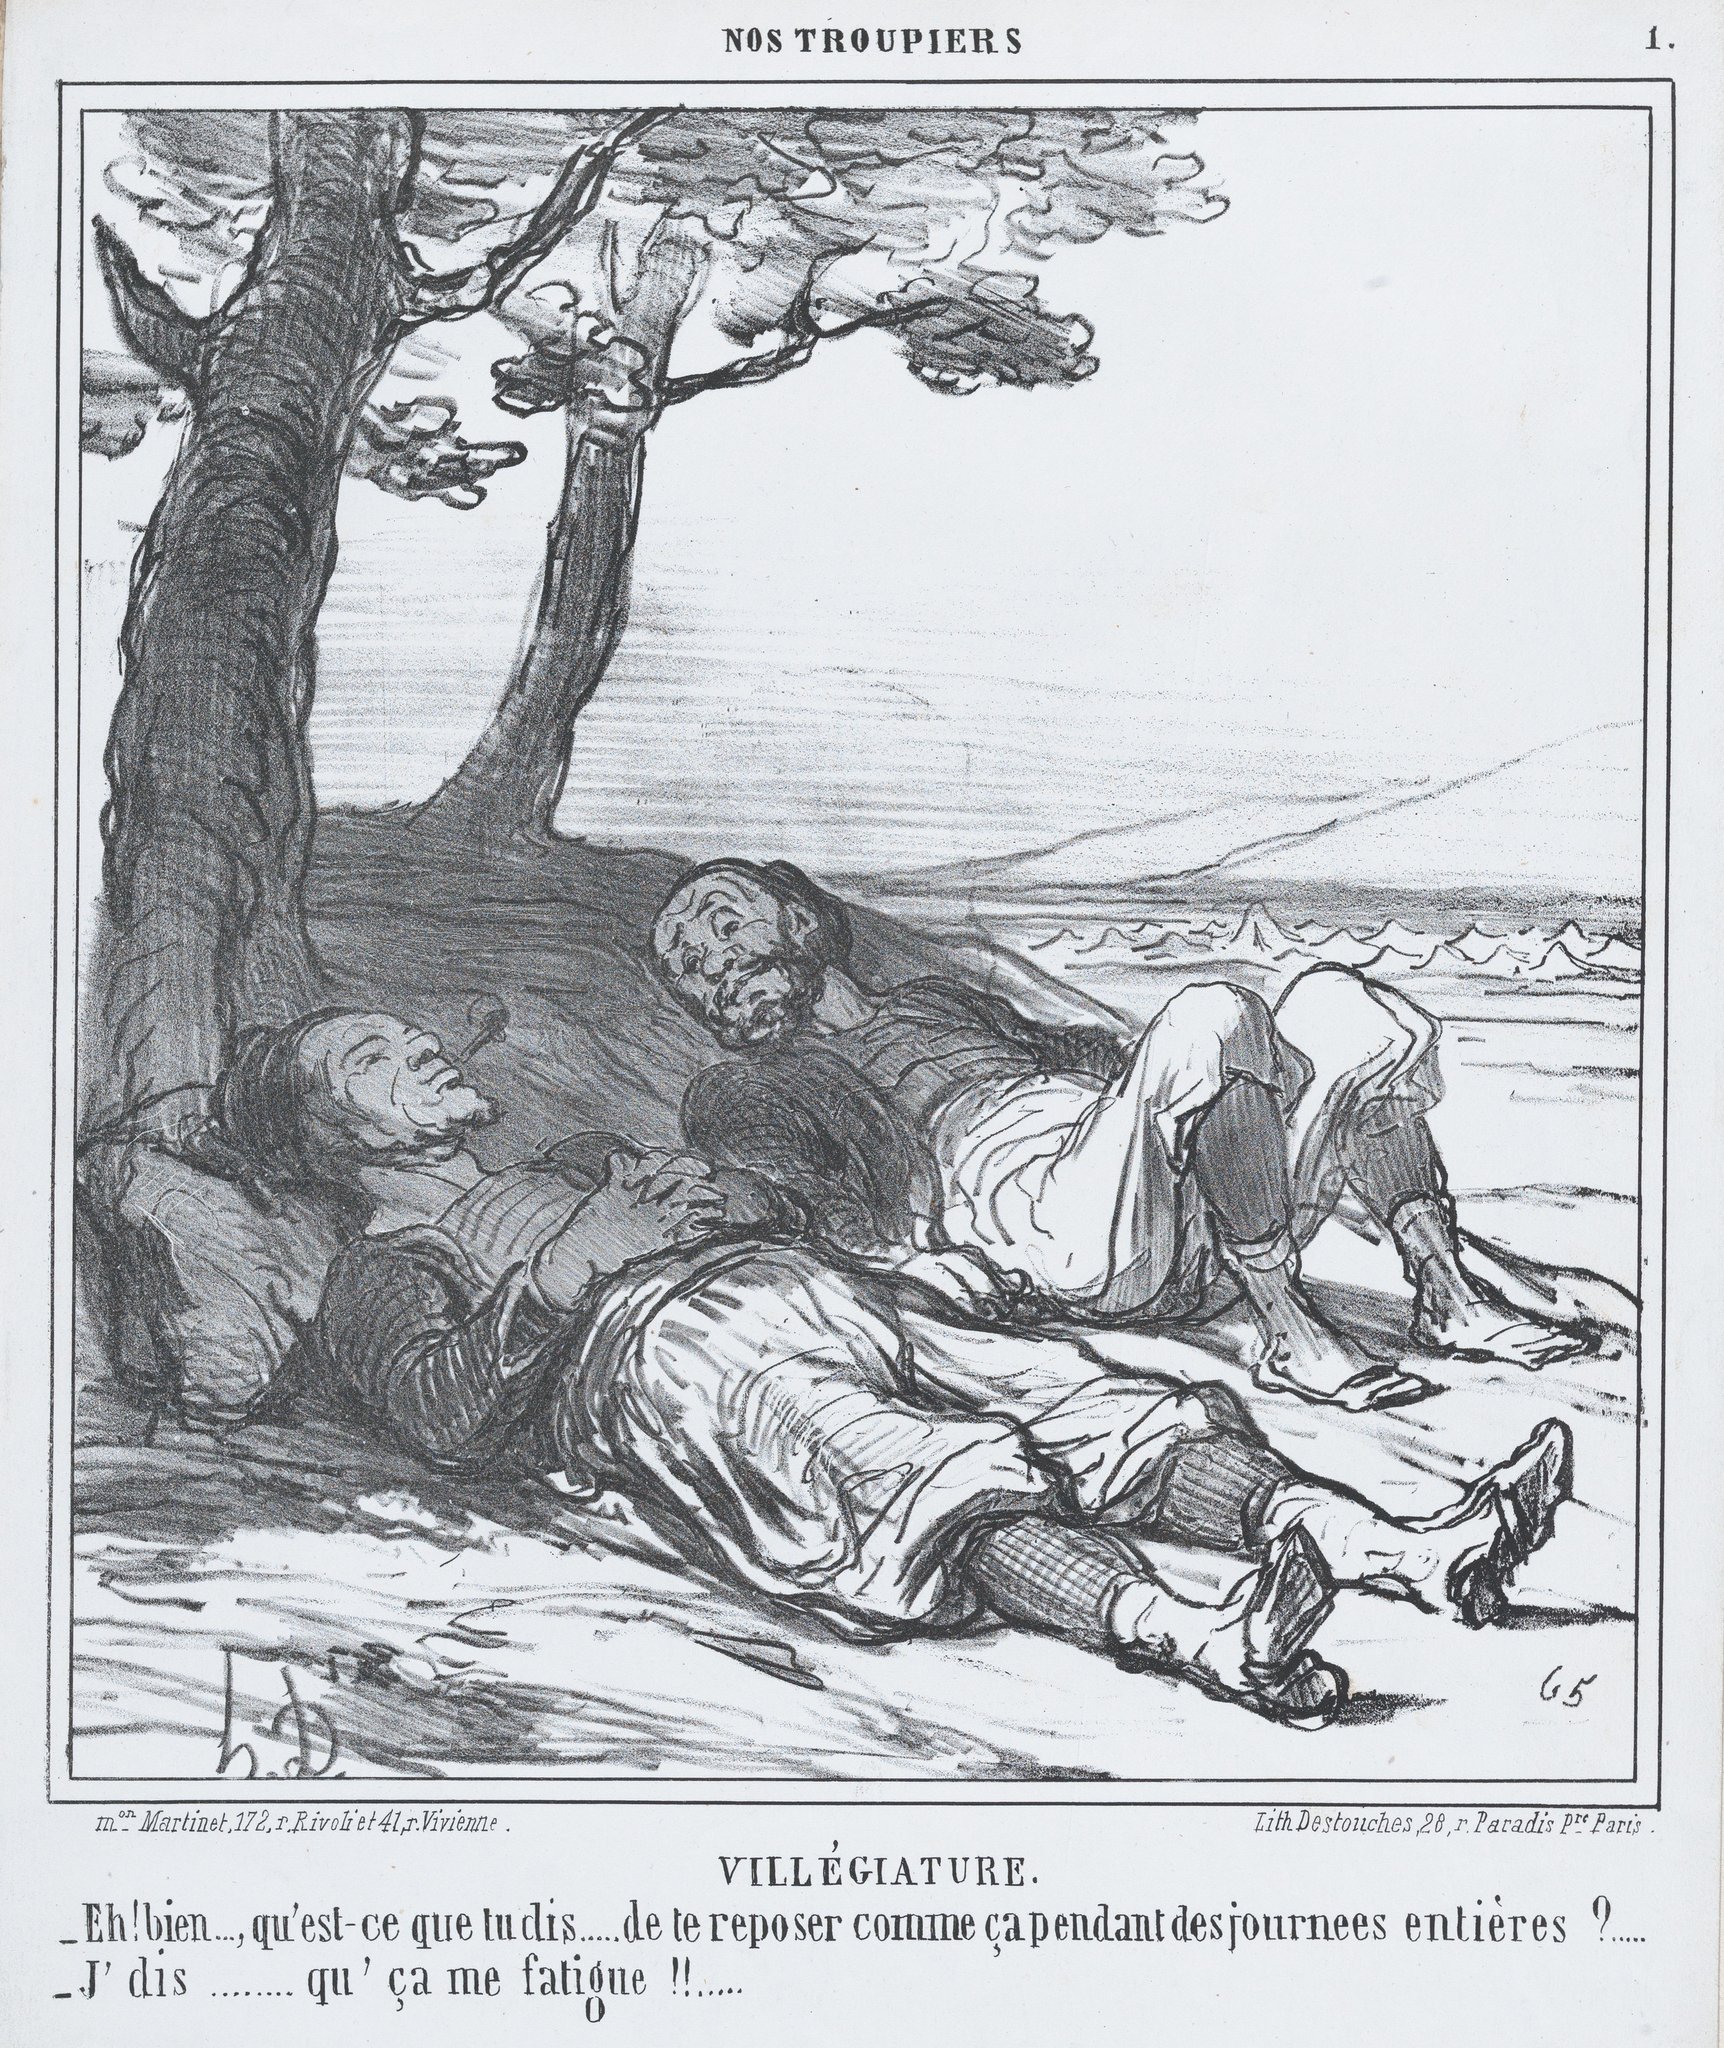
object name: print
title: Villégiature, from Nos Troupiers, published in Le Charivari, July 26, 1859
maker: honoré daumier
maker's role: artist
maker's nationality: french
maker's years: 1808-1879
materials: paper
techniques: lithograph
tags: men,smoking,trees